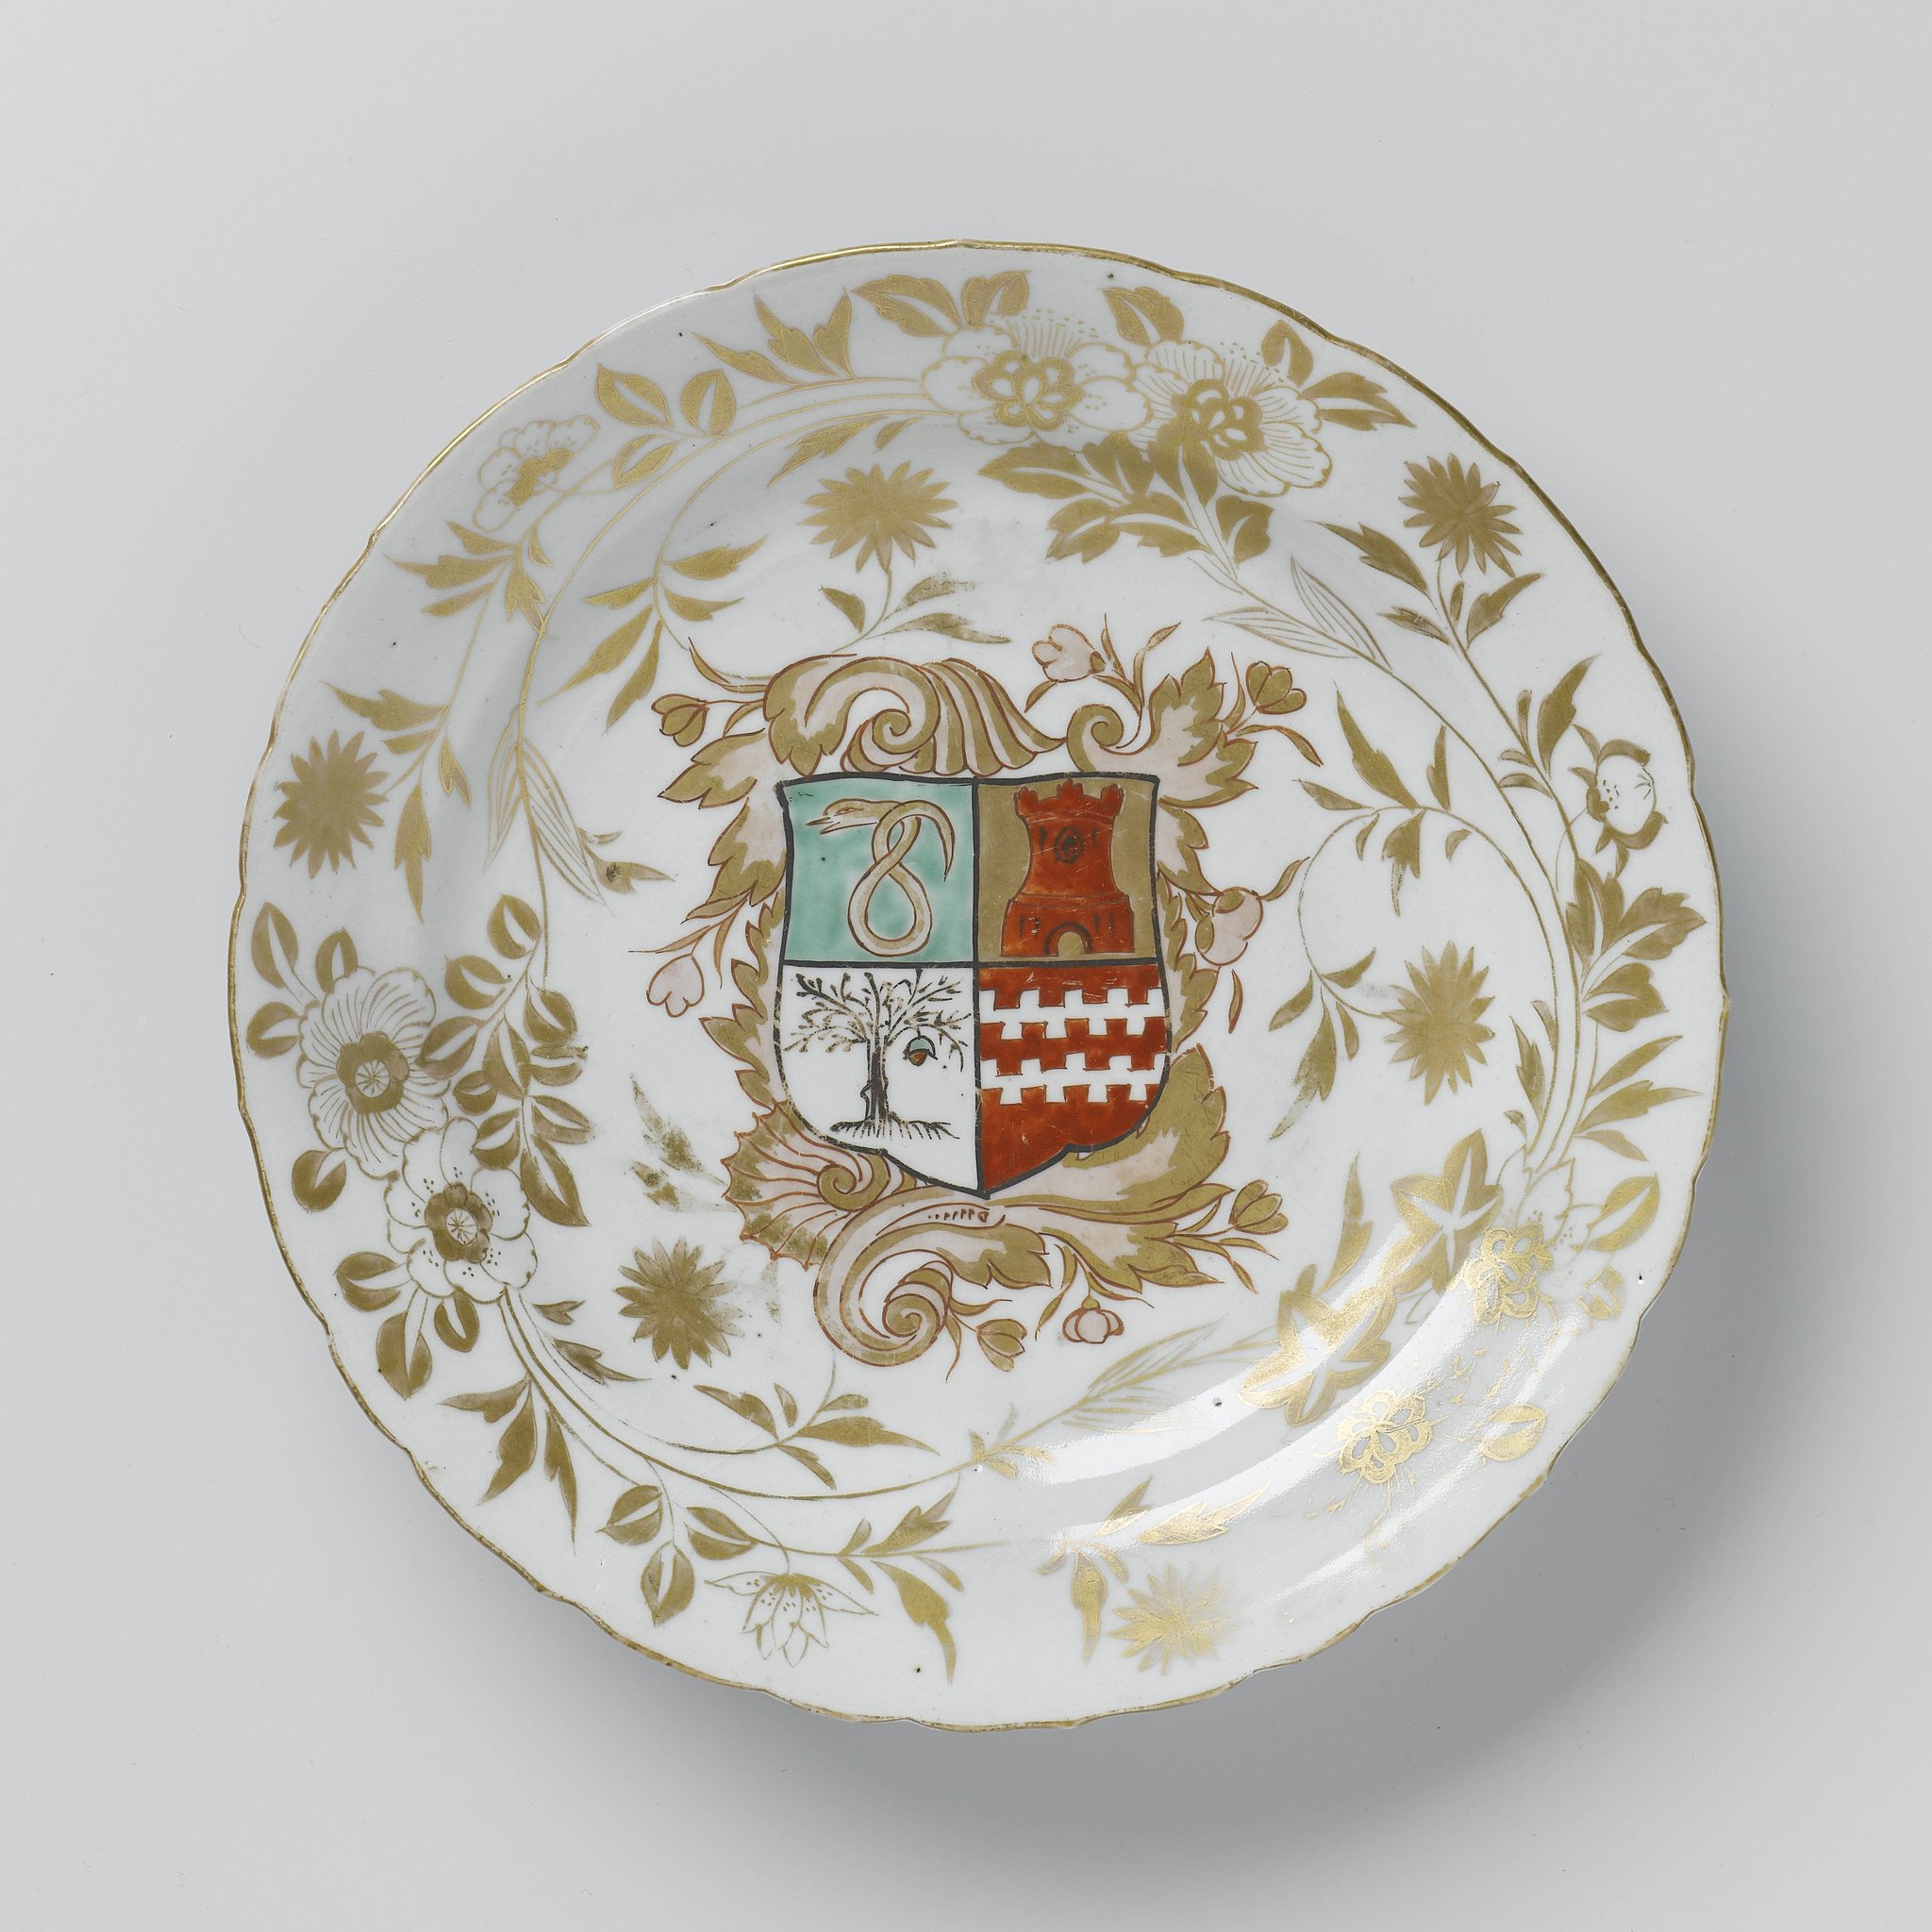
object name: plate dish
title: Plate with a coat of arms and floral scrolls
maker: Anonymous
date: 1710-1730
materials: glaze, gold, paint, porcelain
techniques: firing, gilding, turning, vitrification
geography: japan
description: Plate.Japan, 1700-1750. Chinese and Japanese porcelain decorated in overglaze enamels.